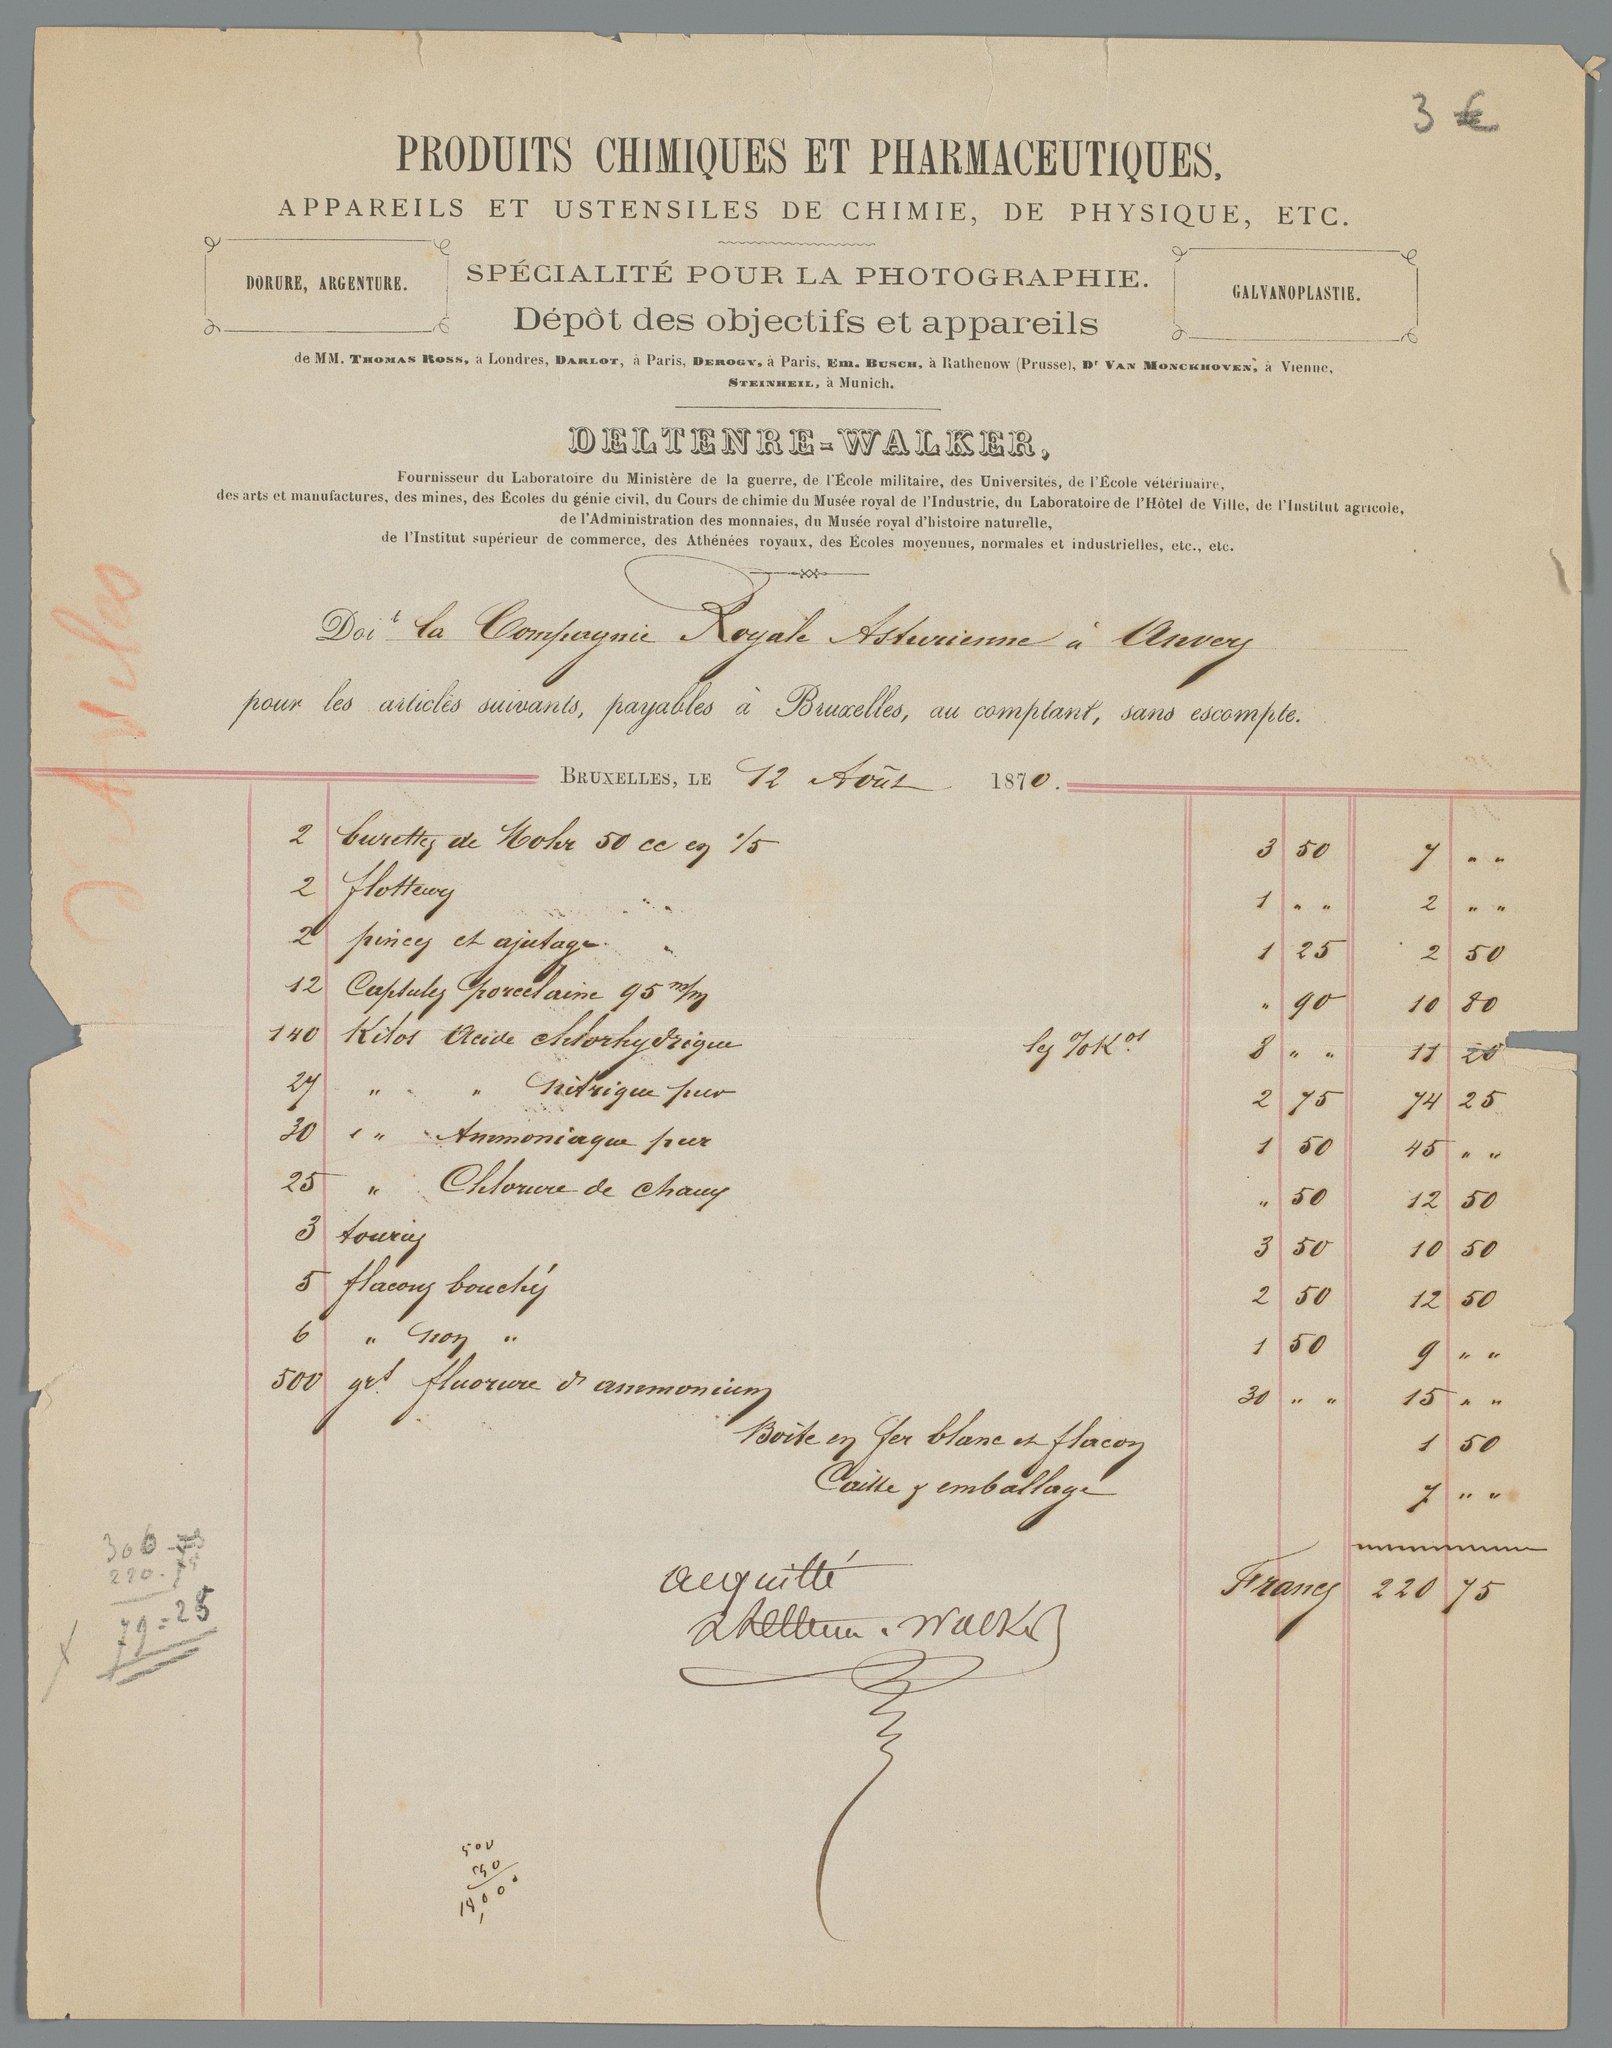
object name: account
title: Rekening van de firma Deltendre-Walker gericht aan de Compagnie royale asturienne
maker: léon deltenre-walker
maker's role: fotograaf, handelaar, redacteur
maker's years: 1819-1881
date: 1870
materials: ink, paper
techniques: pen, printing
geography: brussels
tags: photography, cheque, draft, bill of exchange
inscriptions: inscription: ‘[...]’, inscription: ‘3€’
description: Rekening van de firma Deltendre-Walker gericht aan de Compagnie royale asturienne Anvers, gedateerd op 12 augustus 1870 te Brussel. De rekening bevat diverse artikelen met een totaalbedrag van 220,75 Belgische frank.